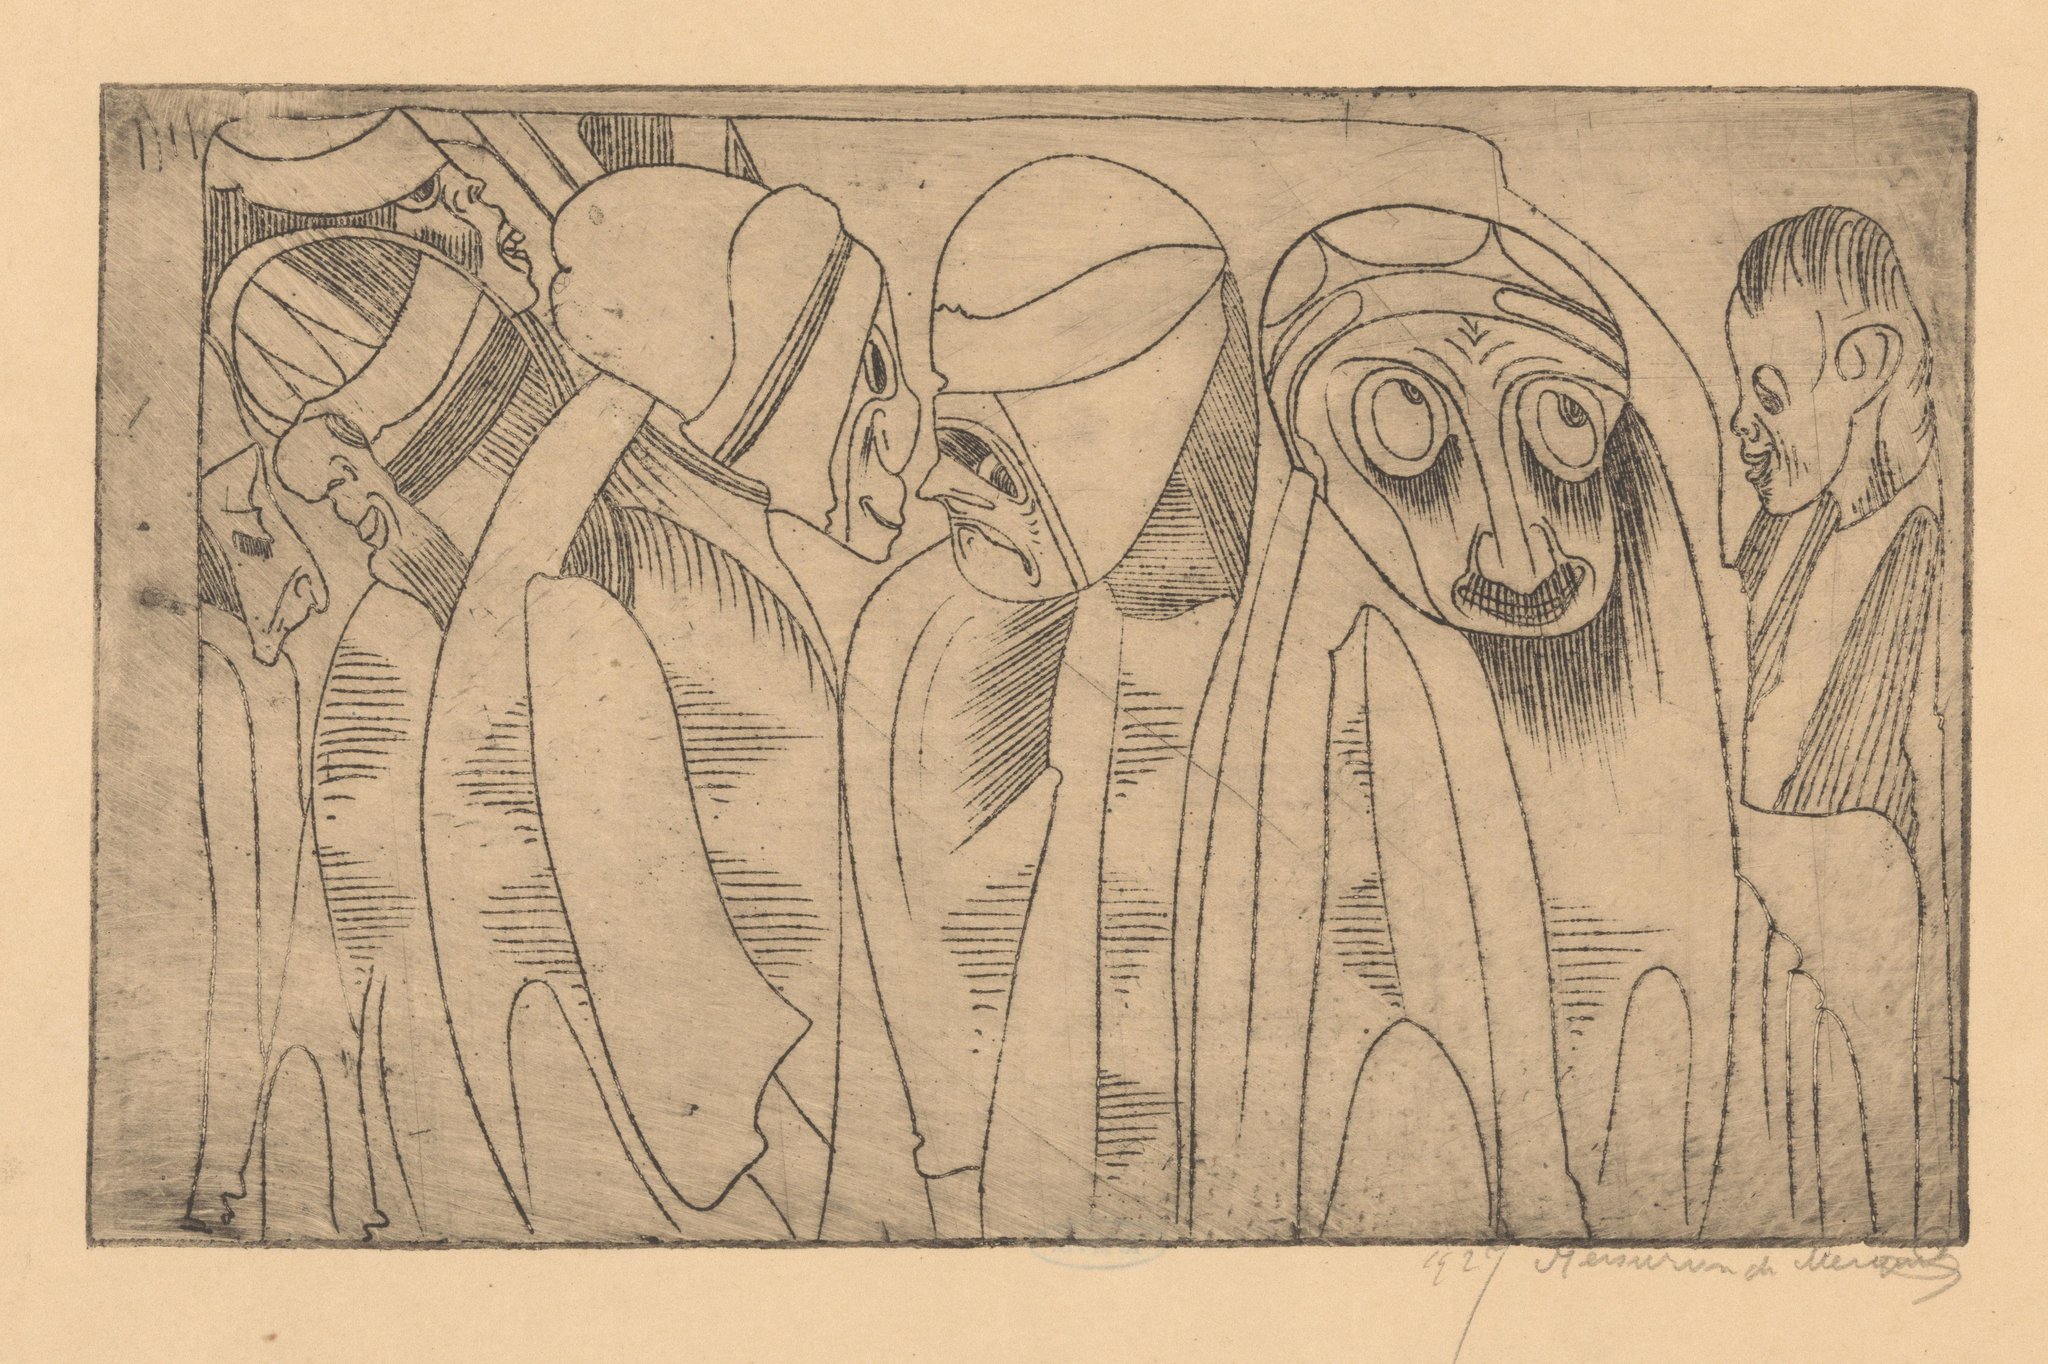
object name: print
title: Zeven staande figuren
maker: samuel jessurun de mesquita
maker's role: draughtsman, print maker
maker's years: 1868-1944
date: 1927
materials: paper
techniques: etching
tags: caricatures (human types), moustache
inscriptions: collector's mark: Lugt 2228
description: De tweede figuur van rechts heeft een snor en kijkt omhoog.